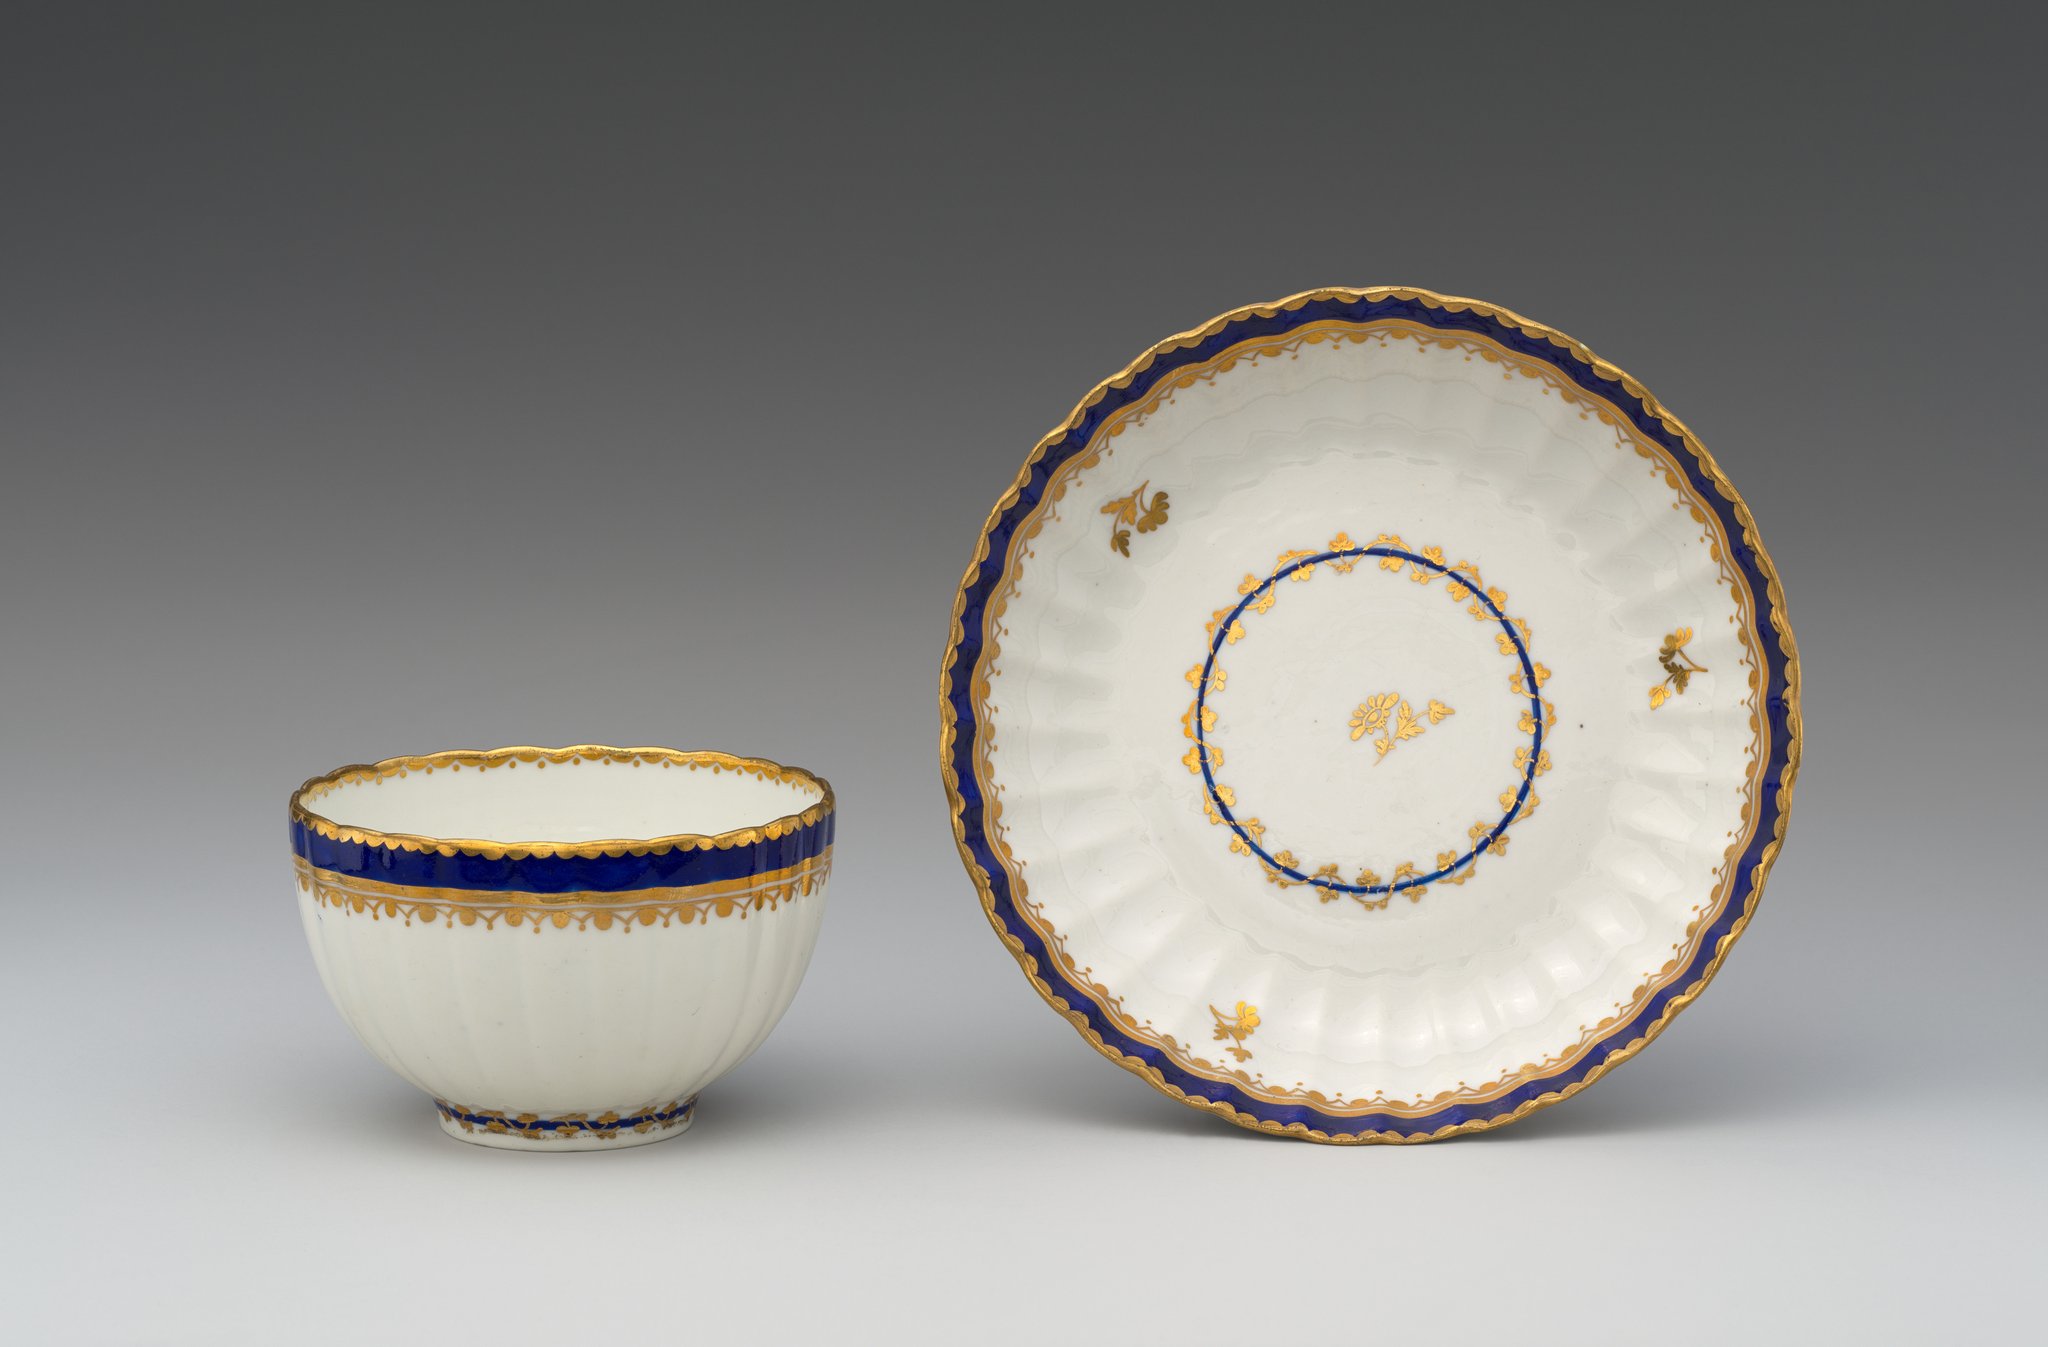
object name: cup and saucer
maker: crown derby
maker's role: maker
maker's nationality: british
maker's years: 1750-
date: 1785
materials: soft paste porcelain